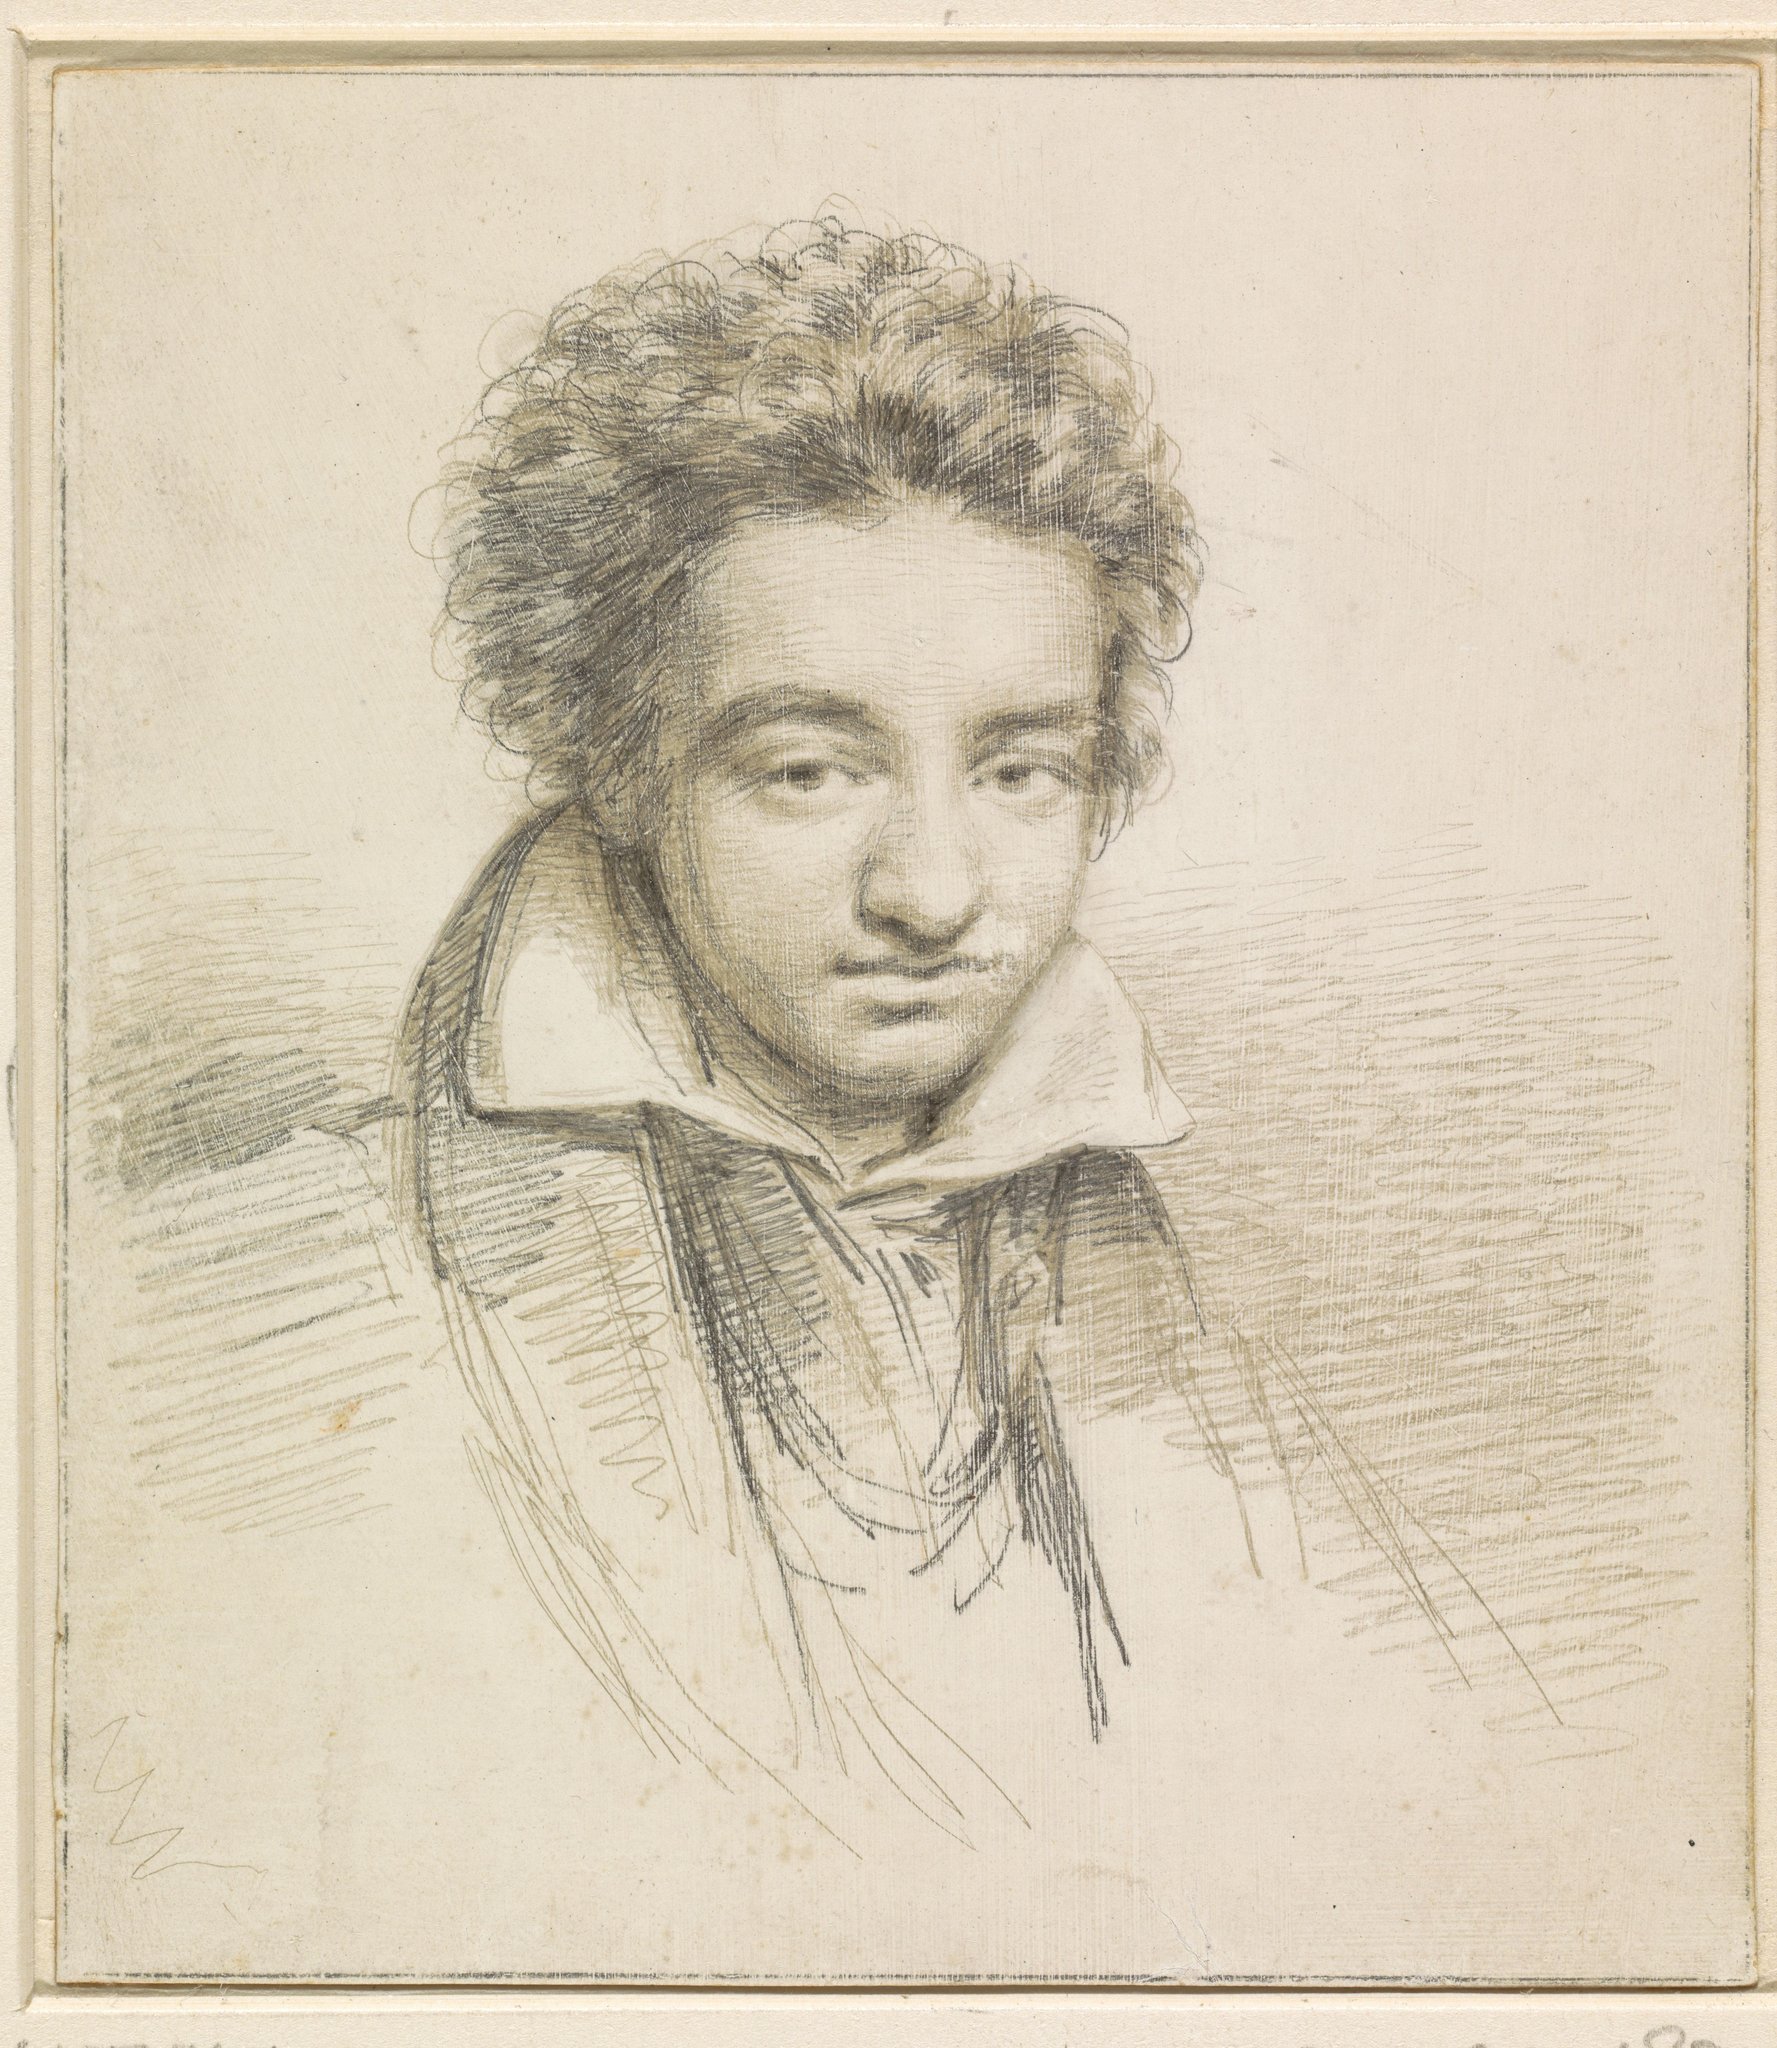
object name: drawing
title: Portret van Cornelis Kruseman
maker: Anonymous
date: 1800-1900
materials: pencil, paper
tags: amsterdam, painter, print maker, draughtsman, cornelis kruseman, historical persons, portrait, self-portrait of painter, portrait, self-portrait of artist